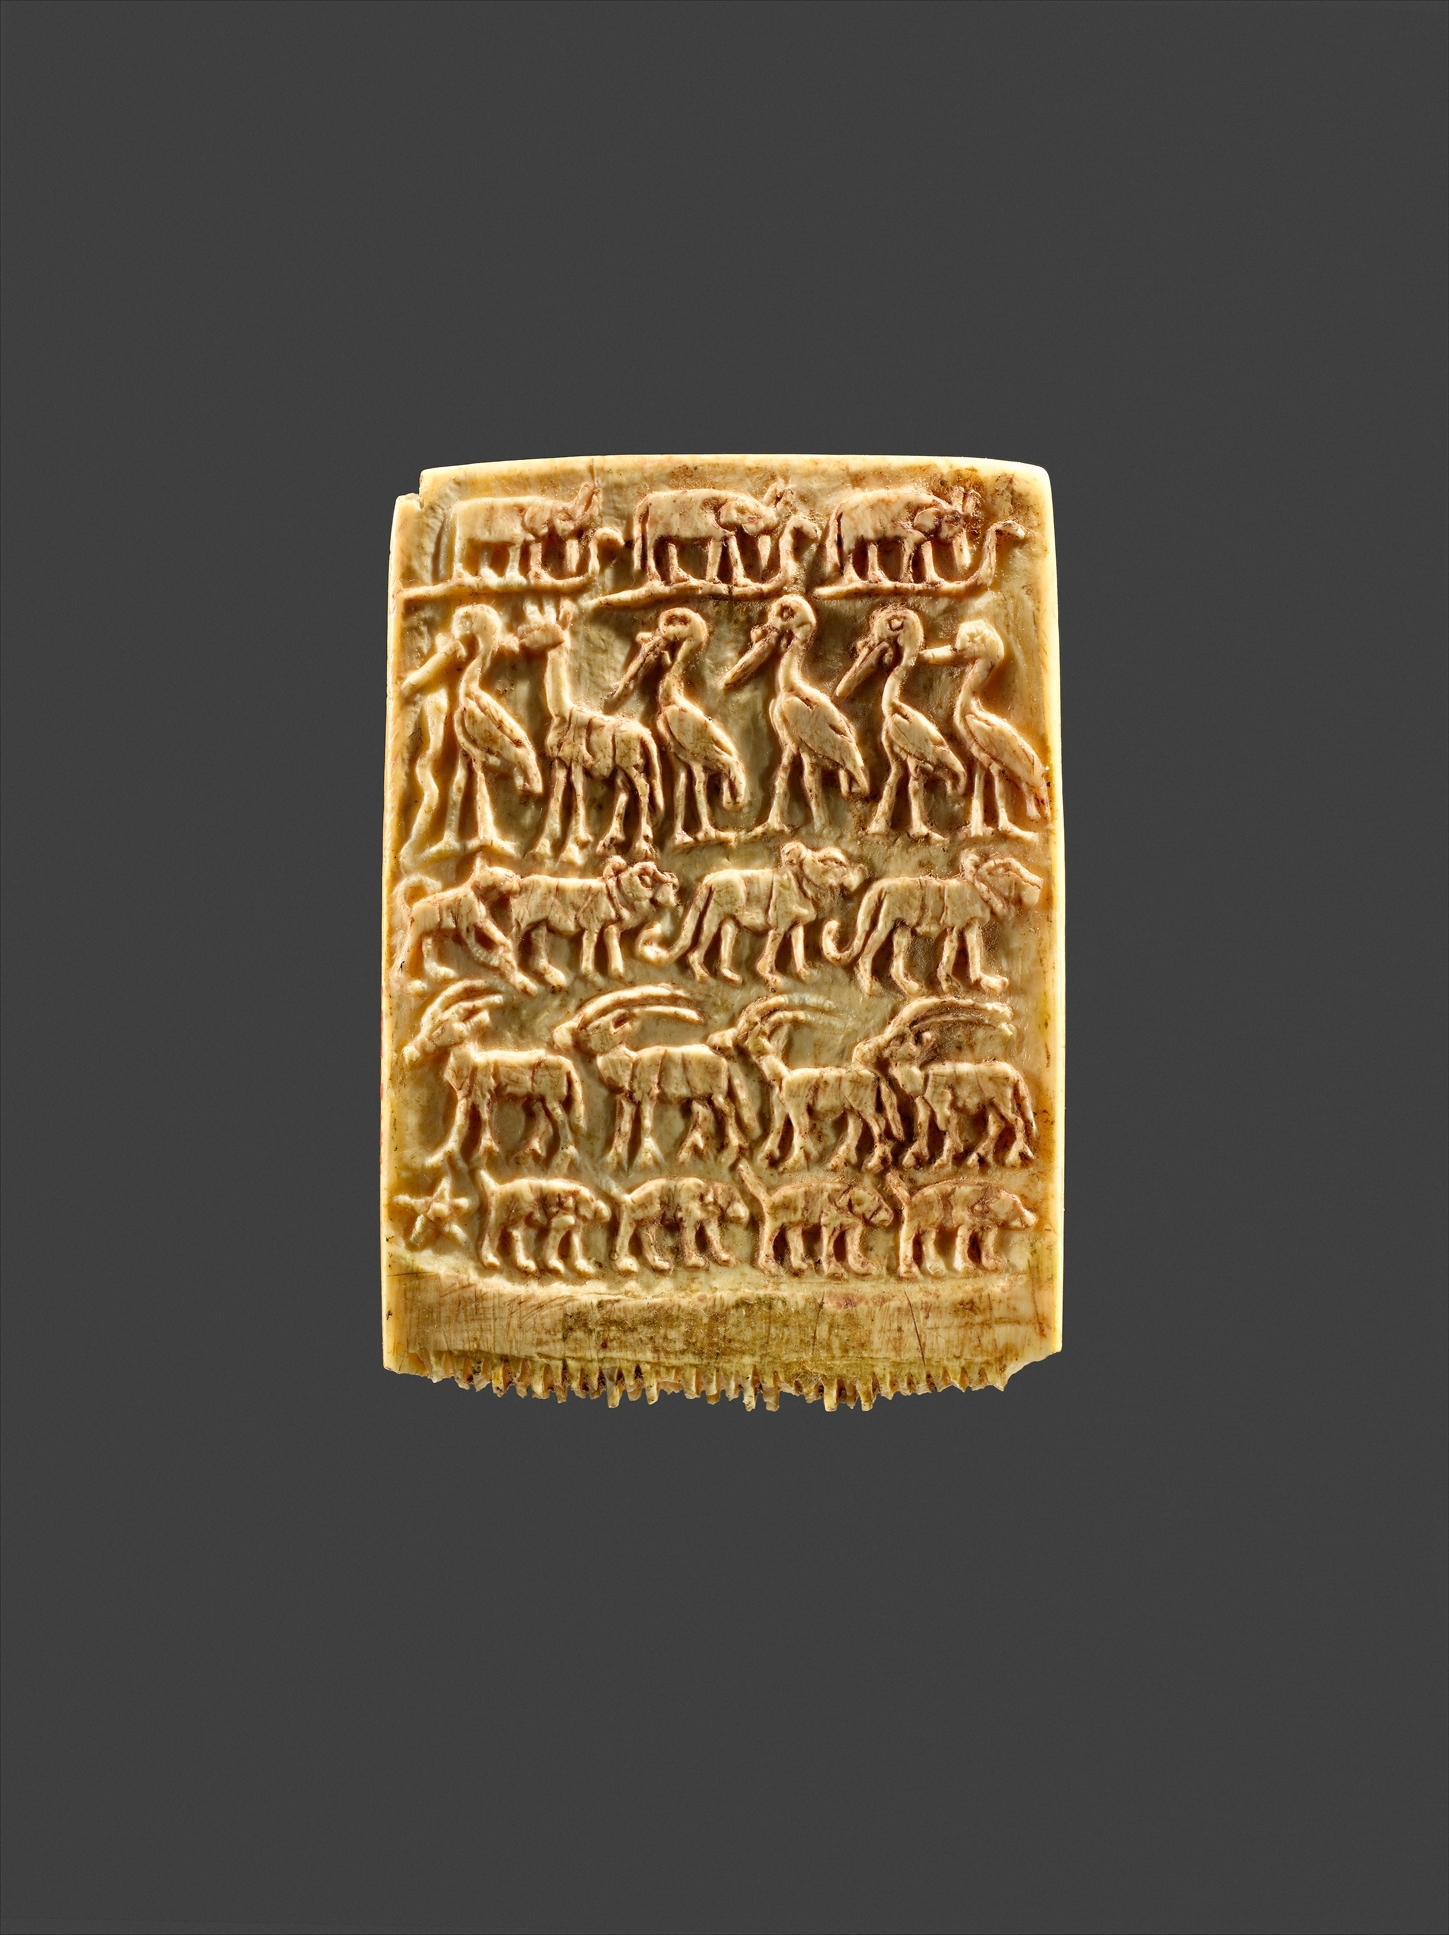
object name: comb, ornamental teeth missing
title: Hair Comb Decorated with Rows of Wild Animals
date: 3200-3100 BCE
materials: ivory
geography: egypt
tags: birds,boars,elephants,snakes